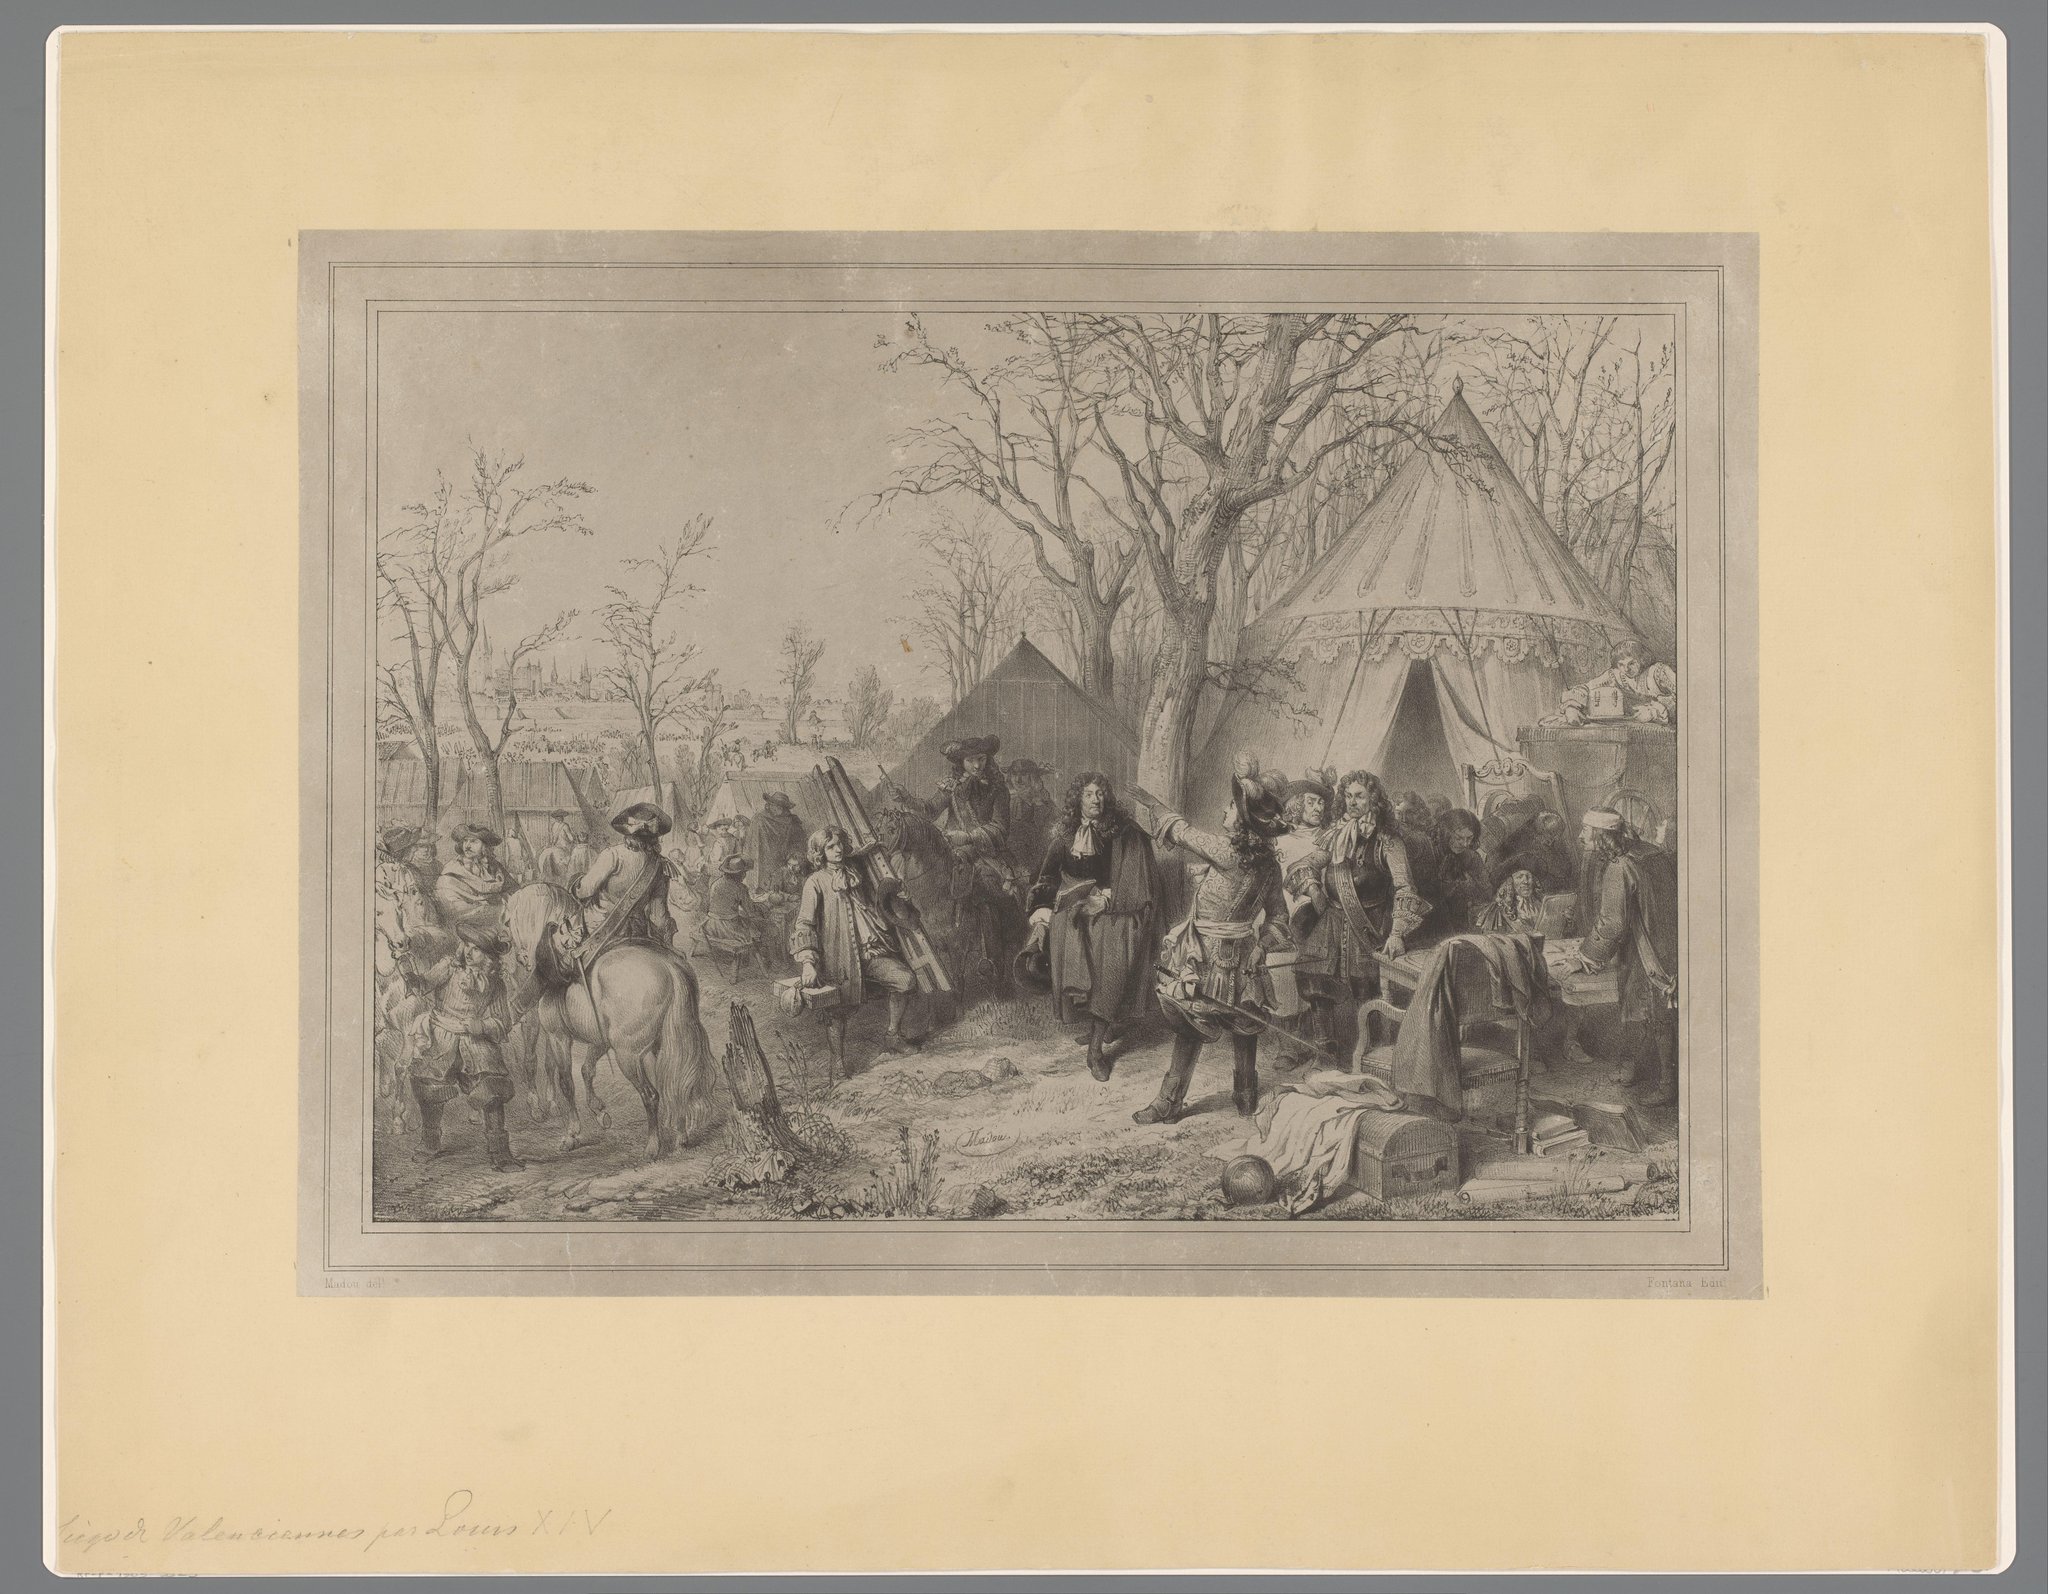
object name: print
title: Adam Frans van der Meulen bij het beleg van Valenciennes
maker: fontana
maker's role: publisher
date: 1838-1842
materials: paper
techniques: lithograph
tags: brussels, paris, painter, draughtsman, adam frans van der meulen, lodewijk xiv (koning van frankrijk), (military) camp with tents, siege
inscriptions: collector's mark: Lugt 2228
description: Adam Frans van der Meulen was hofschilder van Lodewijk XIV en schildert als ooggetuige het beleg van Valenciennes.